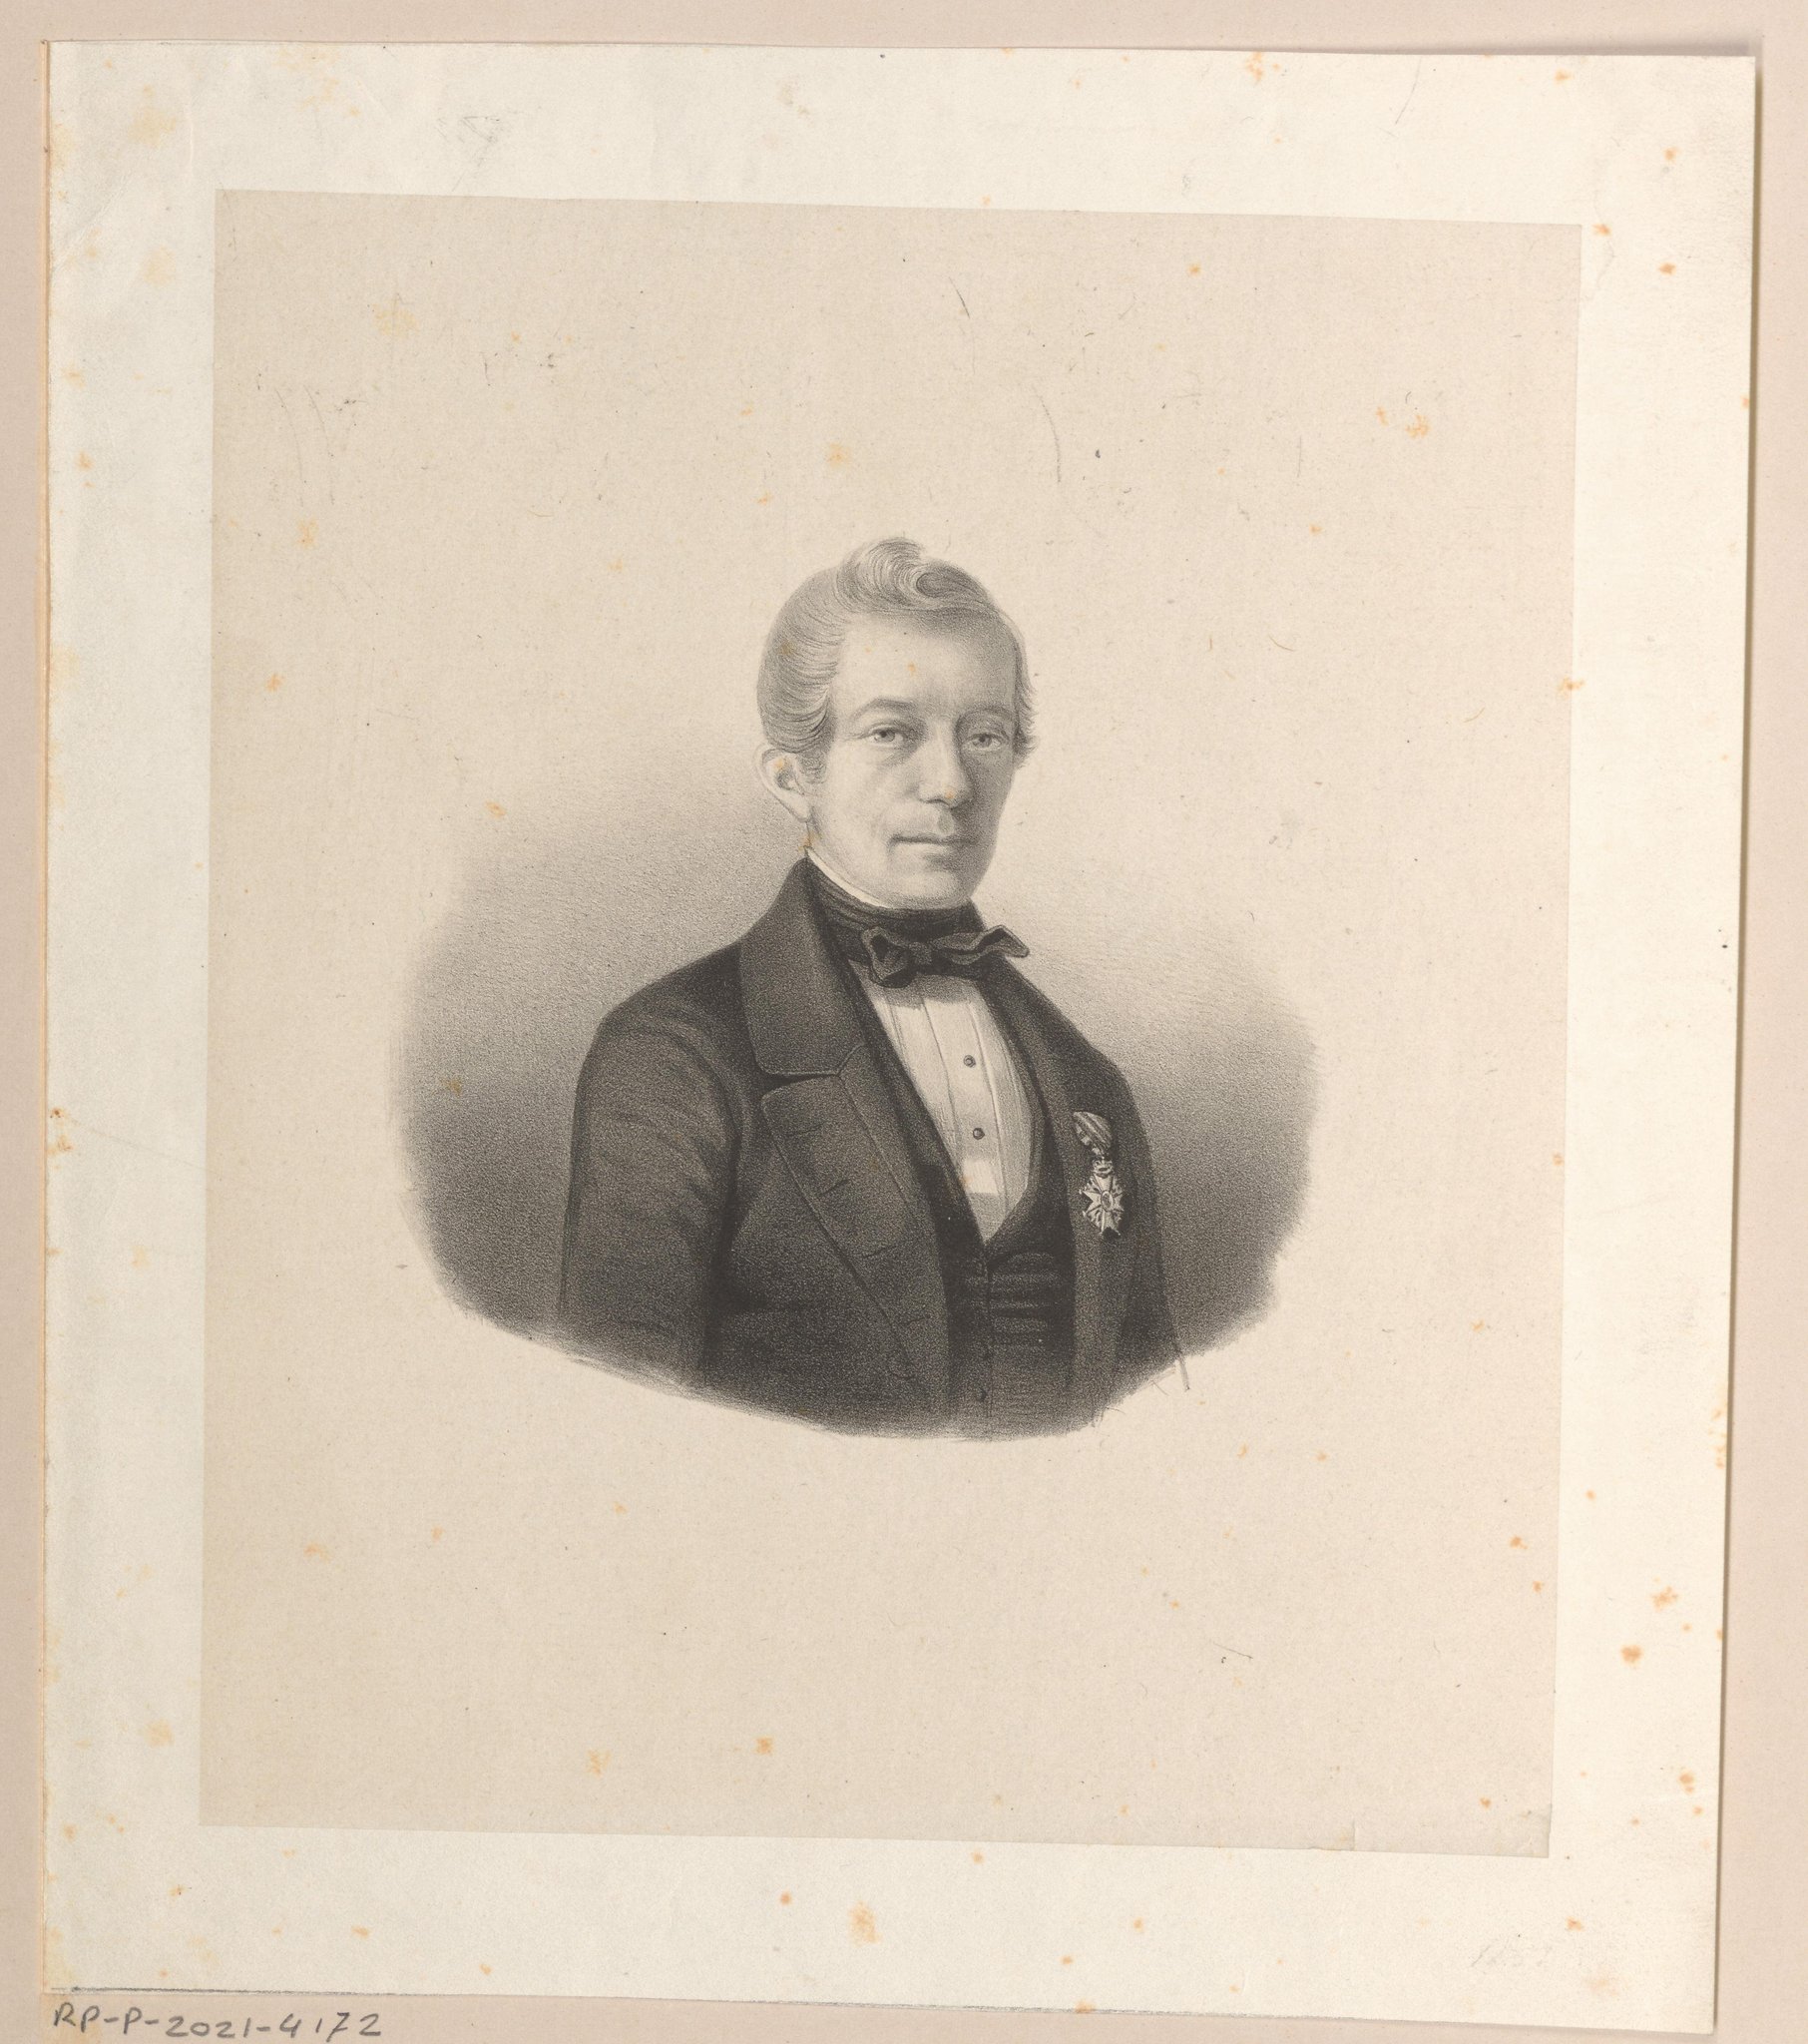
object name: print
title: Portret van Johan Theodoor Hendrik Nedermeyer, ridder van Rosenthal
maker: Anonymous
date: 1816-1899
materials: paper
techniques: lithograph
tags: politician, knighthood order, historical persons, politician, e.g. party leader